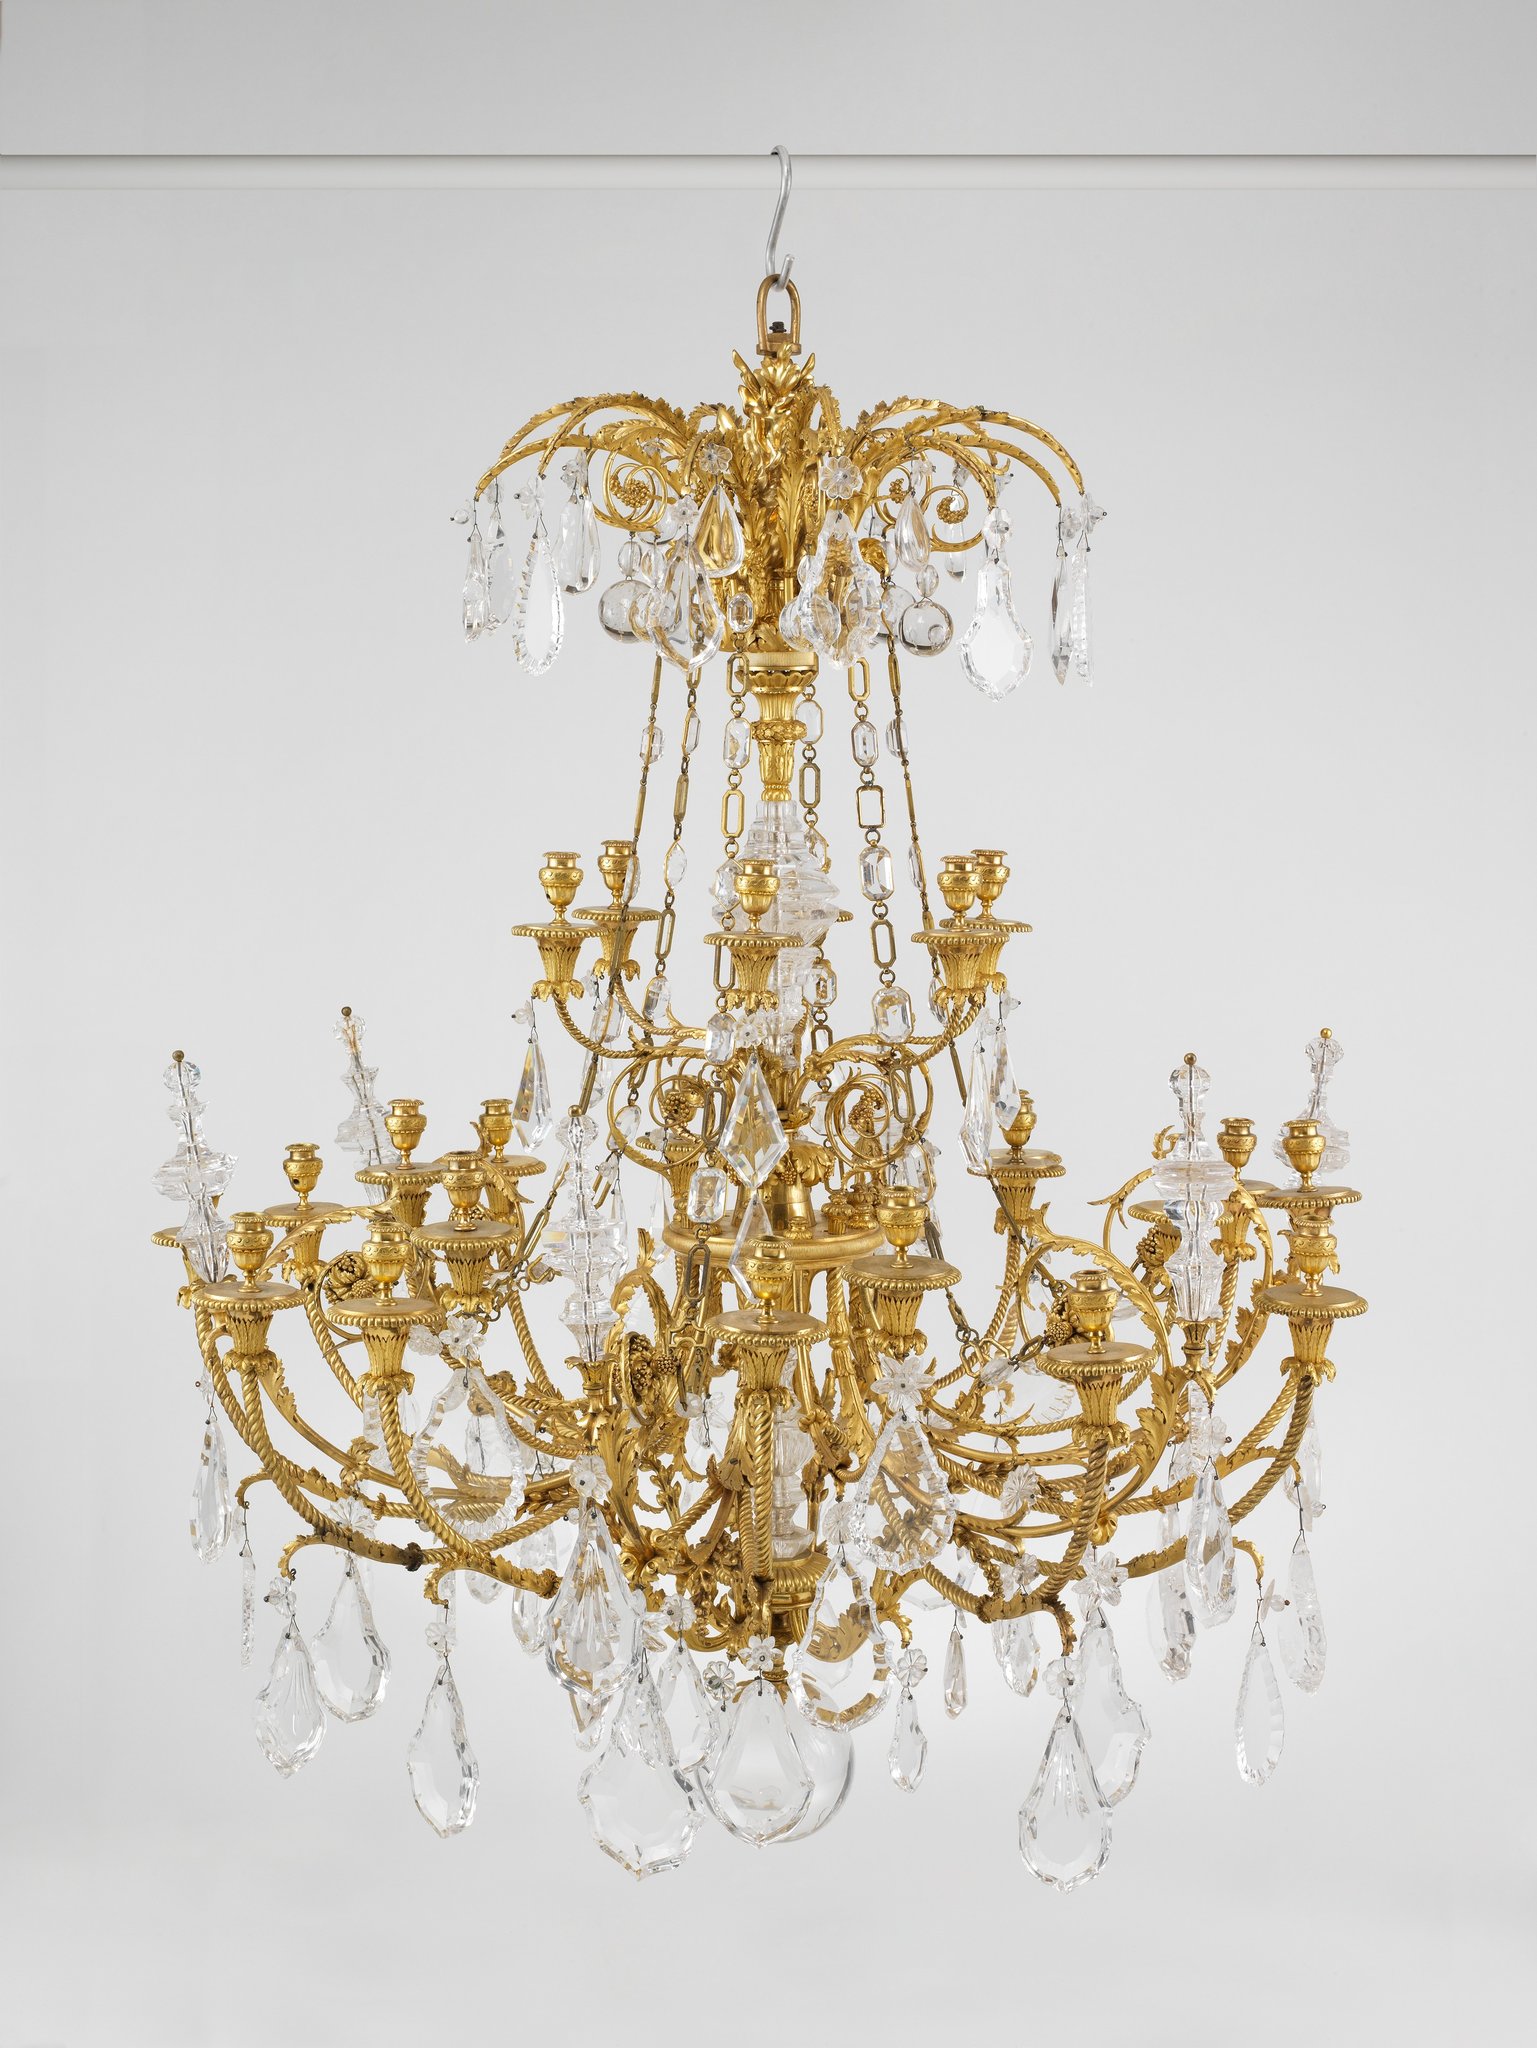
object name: chandelier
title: Twenty-four-light chandelier (lustre) (one of a pair)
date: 1790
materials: gilt bronze, quartz